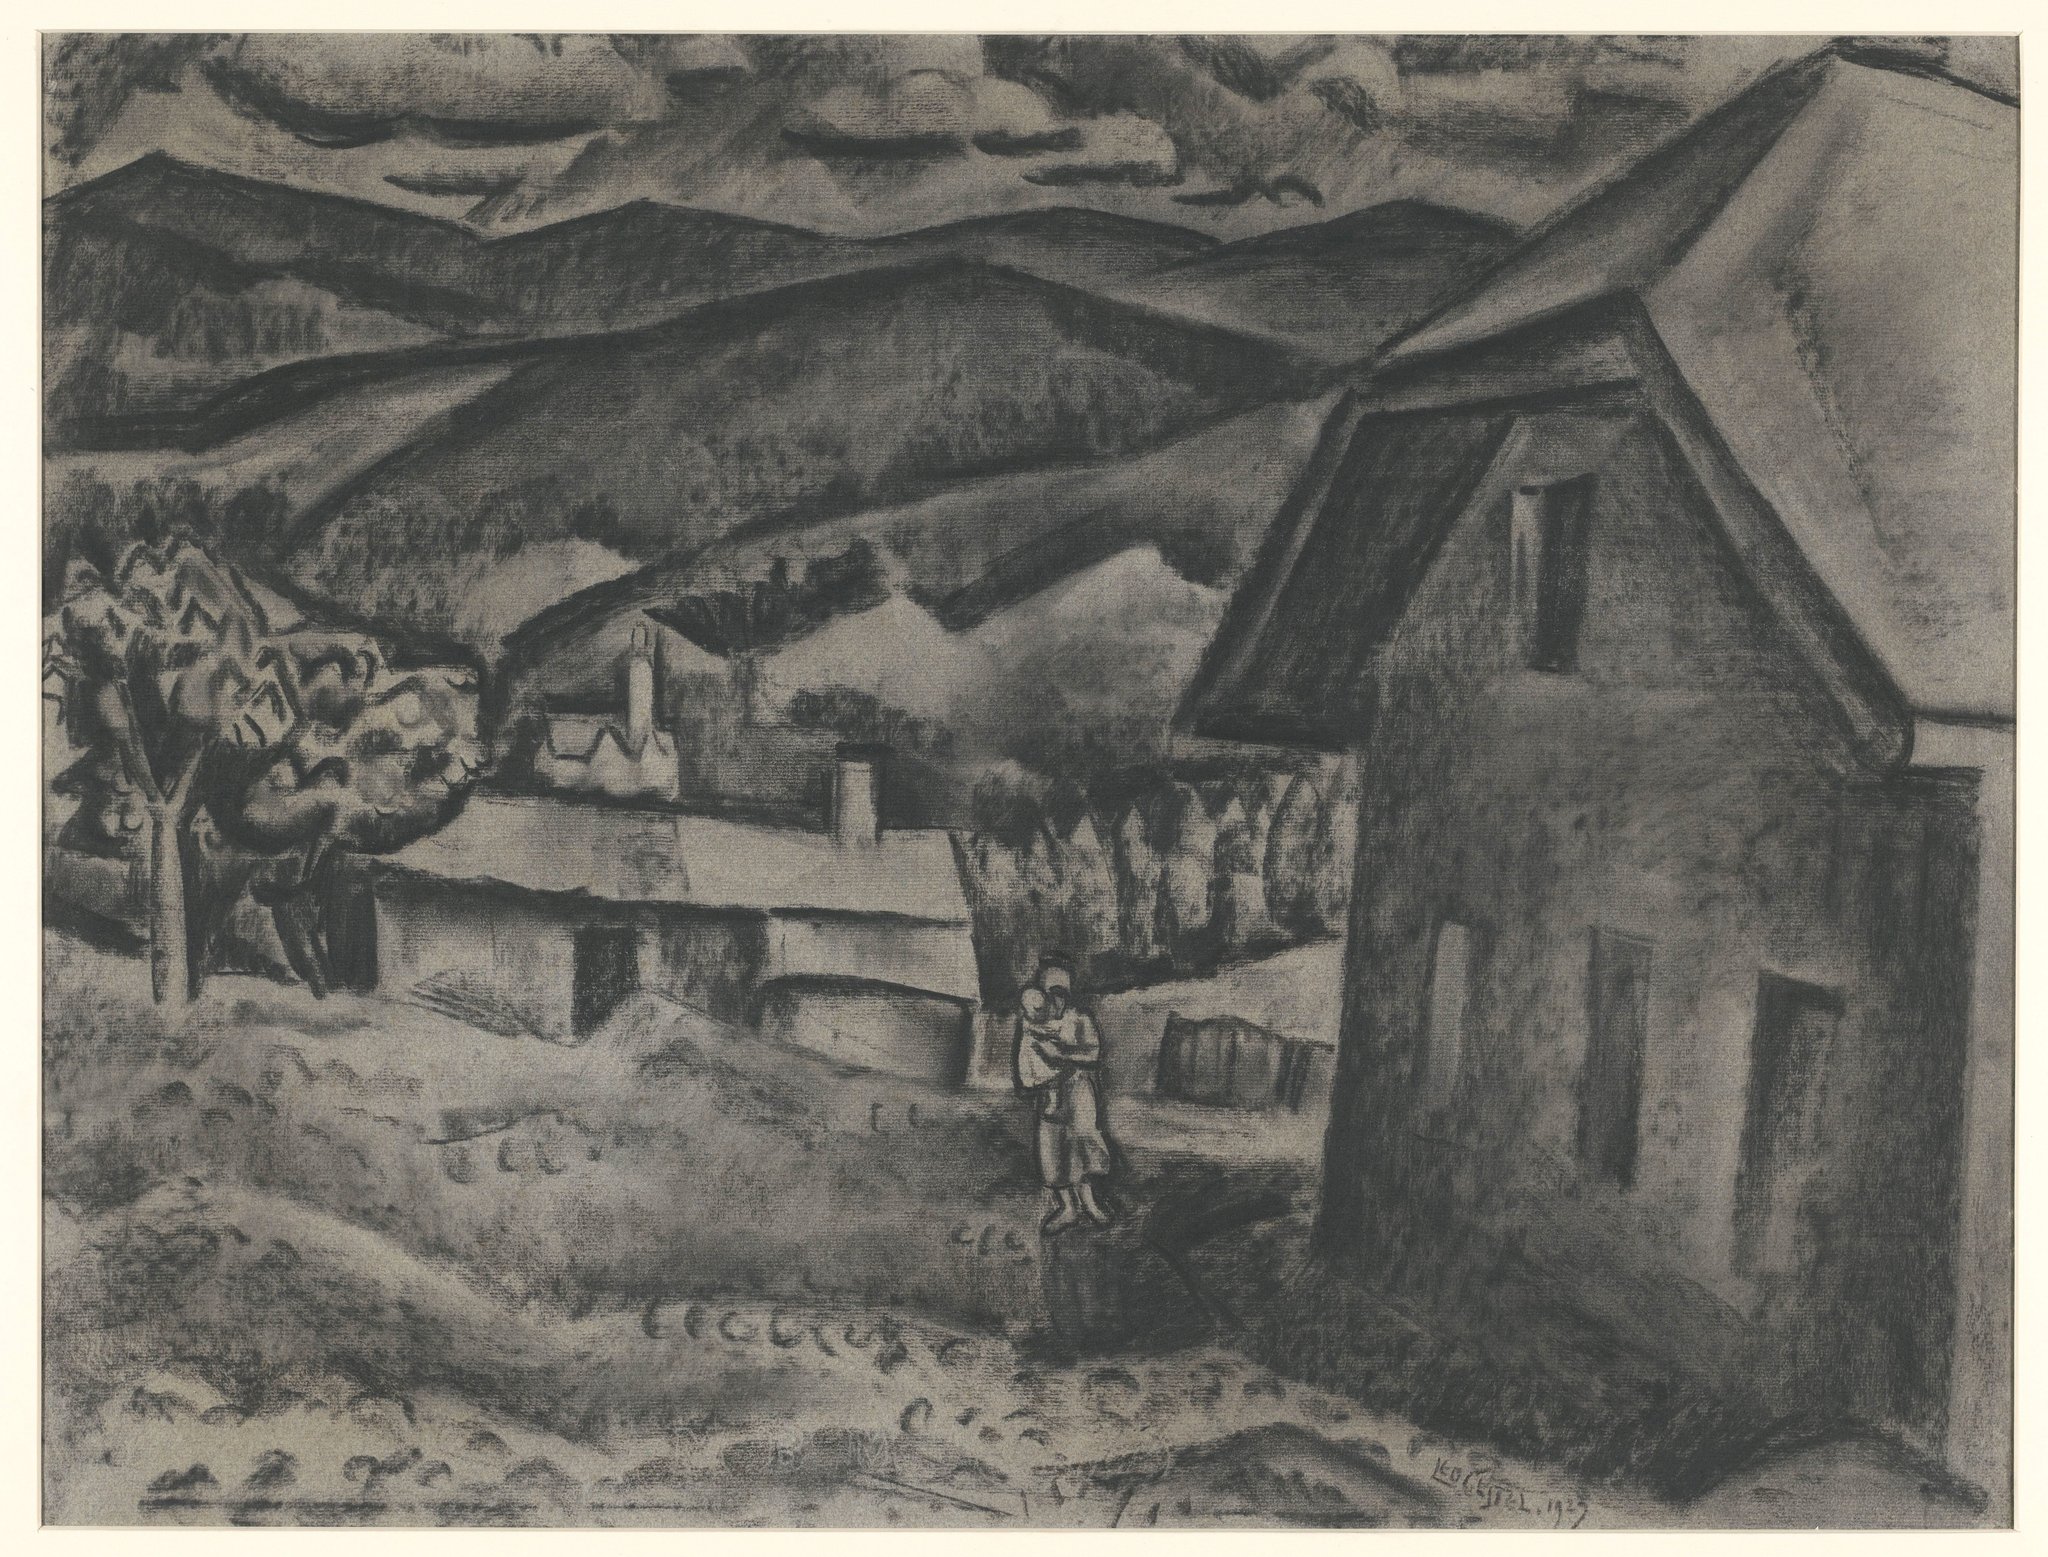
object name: drawing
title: Landschap met vrouw met kind voor een huis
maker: leo gestel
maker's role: draughtsman, print maker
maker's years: 1881-1941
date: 1927-1929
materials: charcoal, paper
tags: landscapes, parents with their children